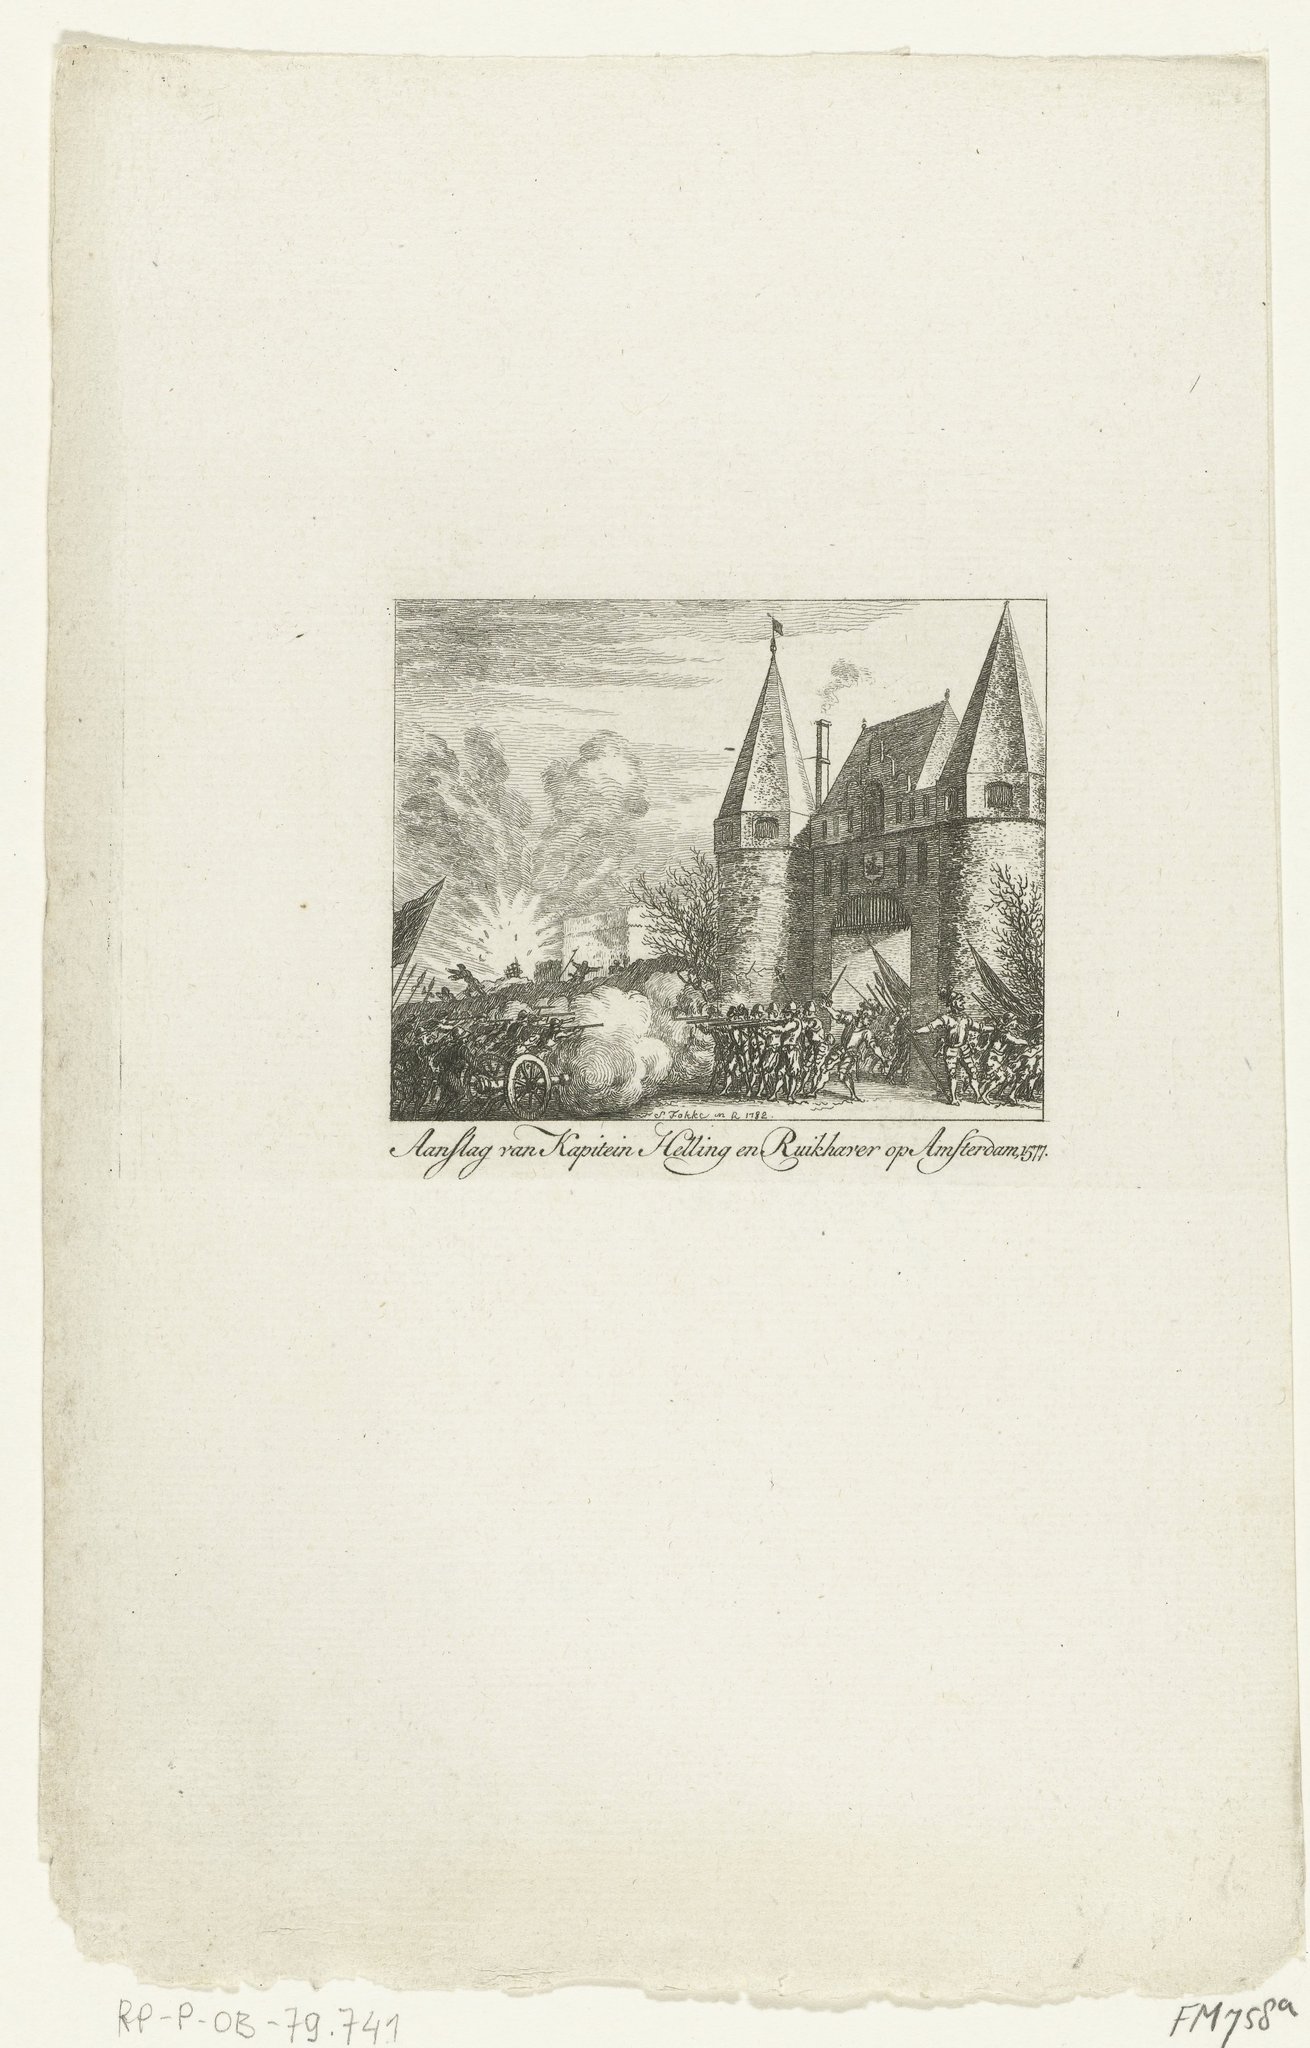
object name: history print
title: Aanslag van Kapitein Helling en Ruikhaver op Amsterdam, 1577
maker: simon fokke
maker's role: draughtsman, print maker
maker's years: 1712-1784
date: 1782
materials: paper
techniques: etching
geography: northern netherlands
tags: haarlem, battle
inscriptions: date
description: Staat met de letter. Volgens de catalogus van de Atlas van Stolk onderdeel van een serie van 7 prentjes van straatoproer te Amsterdam, in 1781 verschenen.